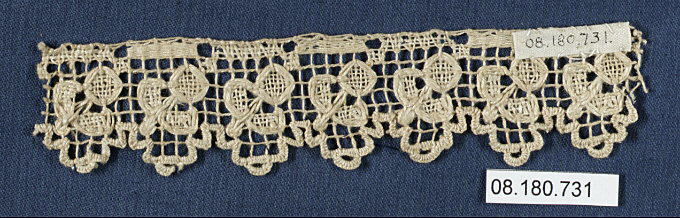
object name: fragment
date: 1801-1900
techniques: embroidery